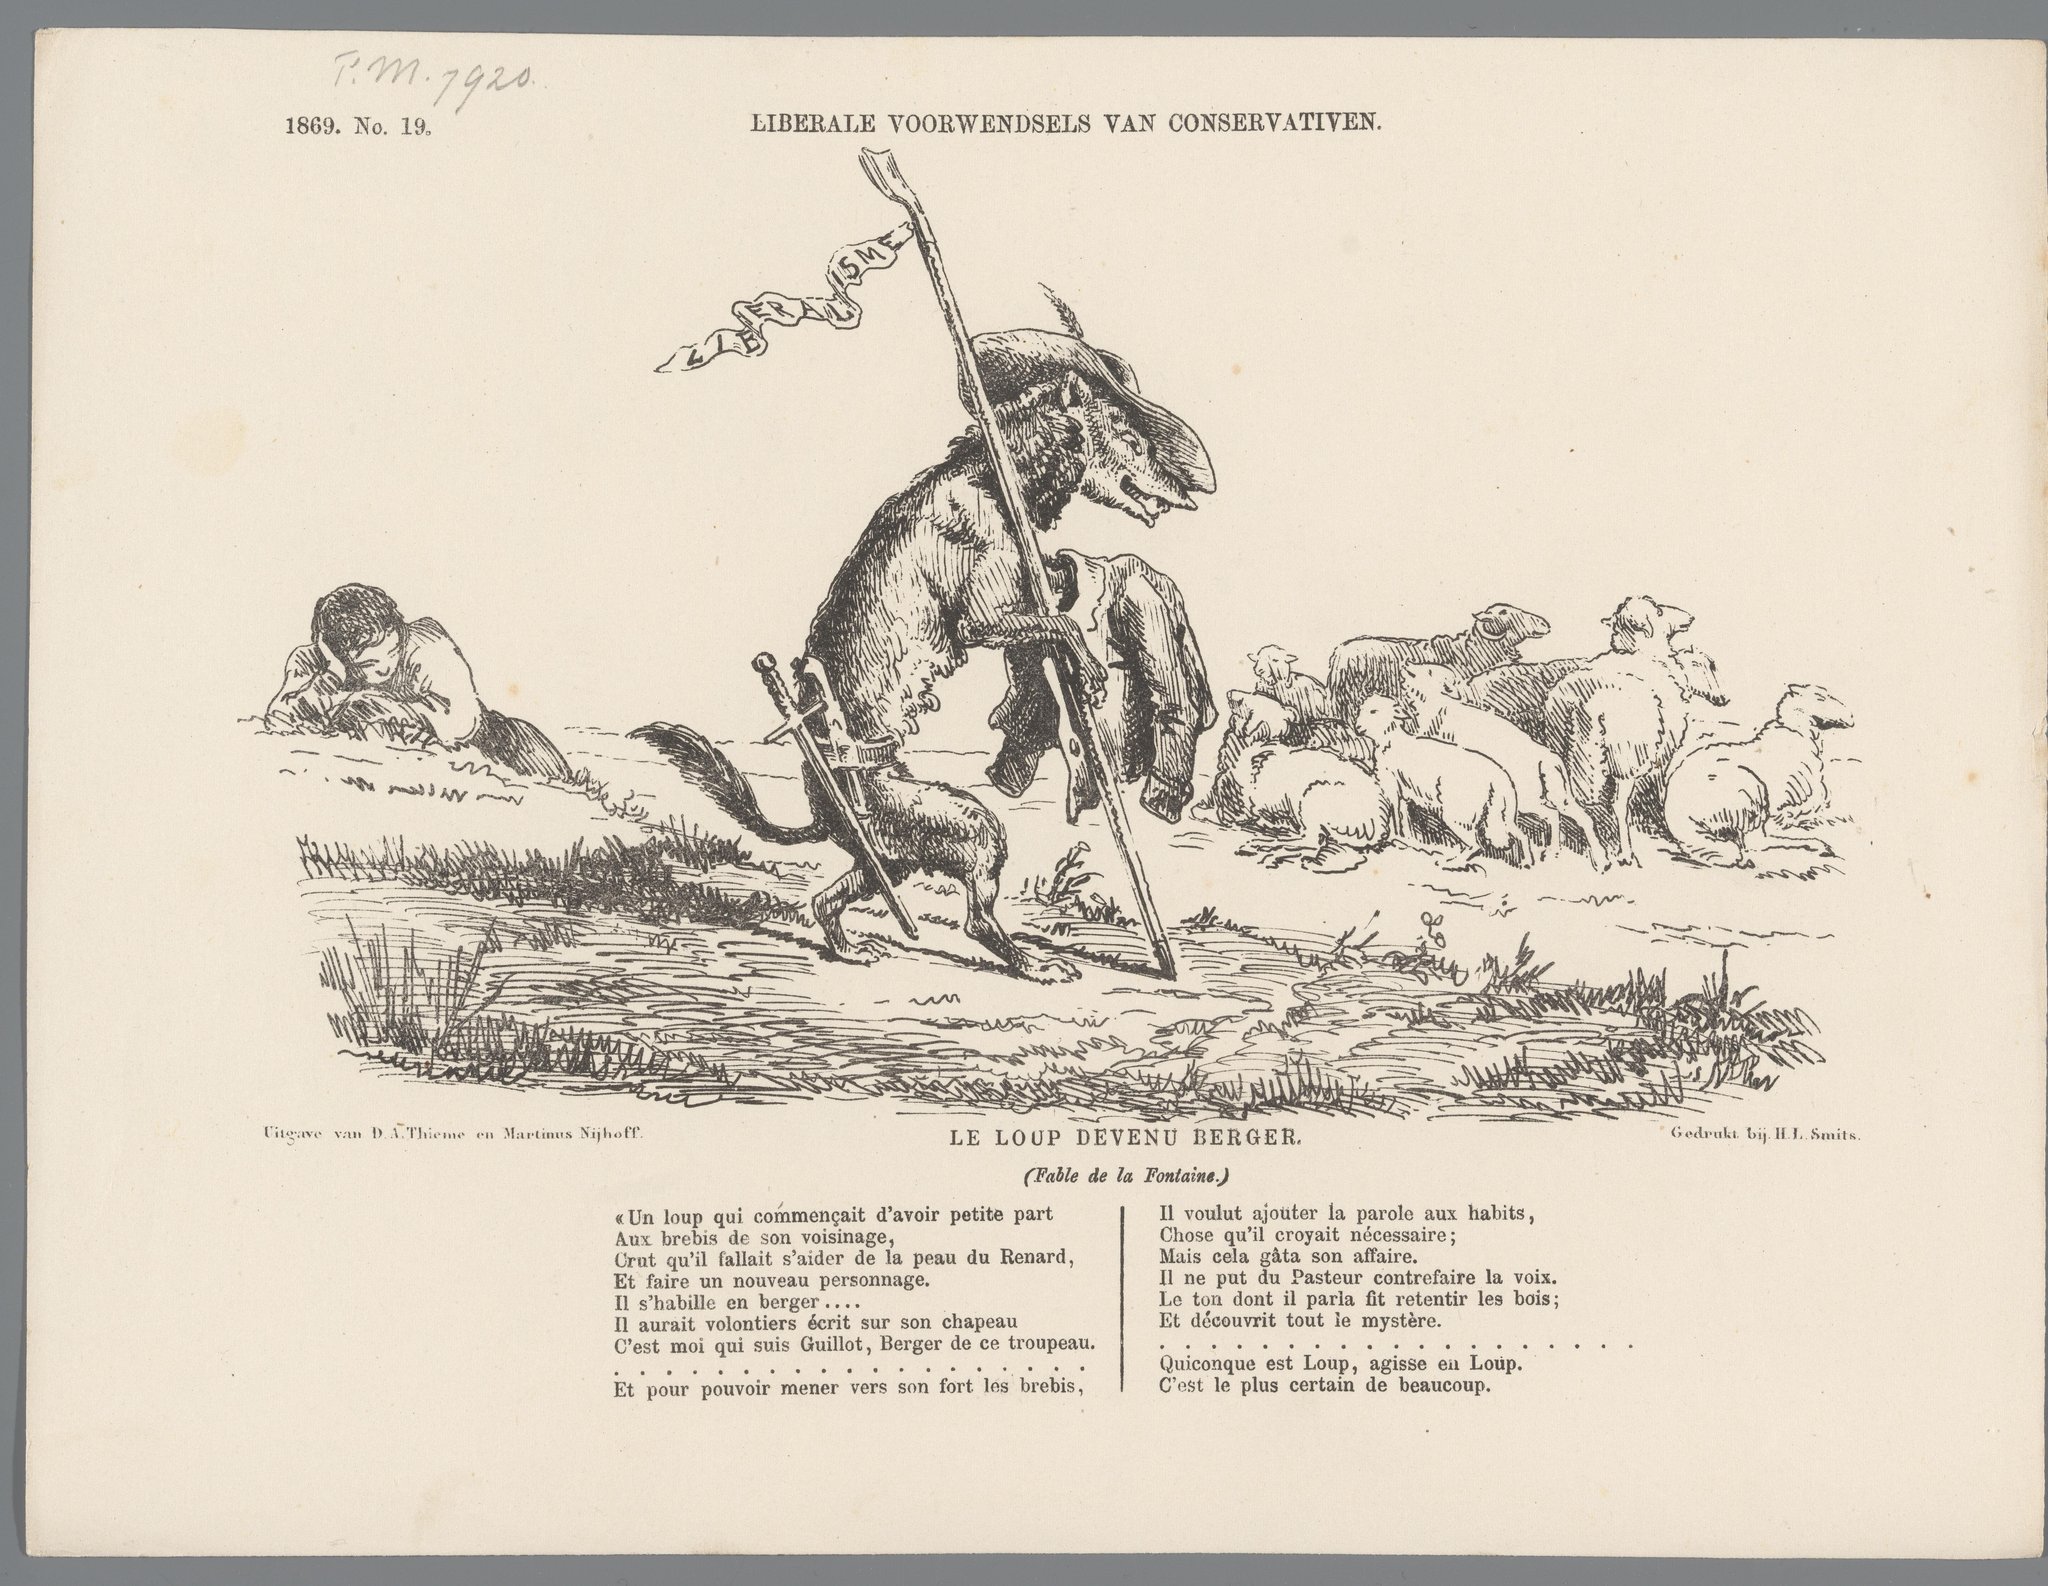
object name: print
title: Liberale voorwendsels van conservatieven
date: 1869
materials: paper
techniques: lithograph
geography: the hague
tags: fable of reynard the fox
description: Spotprent op de houding van de conservatieven bij de herziening van het kiestabel. Reinaert de vos (conservatieven) verkleedt zich als herder (liberalen) bij een kudde schapen. Naar de fabel van De la Fontaine. Plaat verschenen bij het weekblad De Nederlandsche Spectator, nr. 19, 1869.